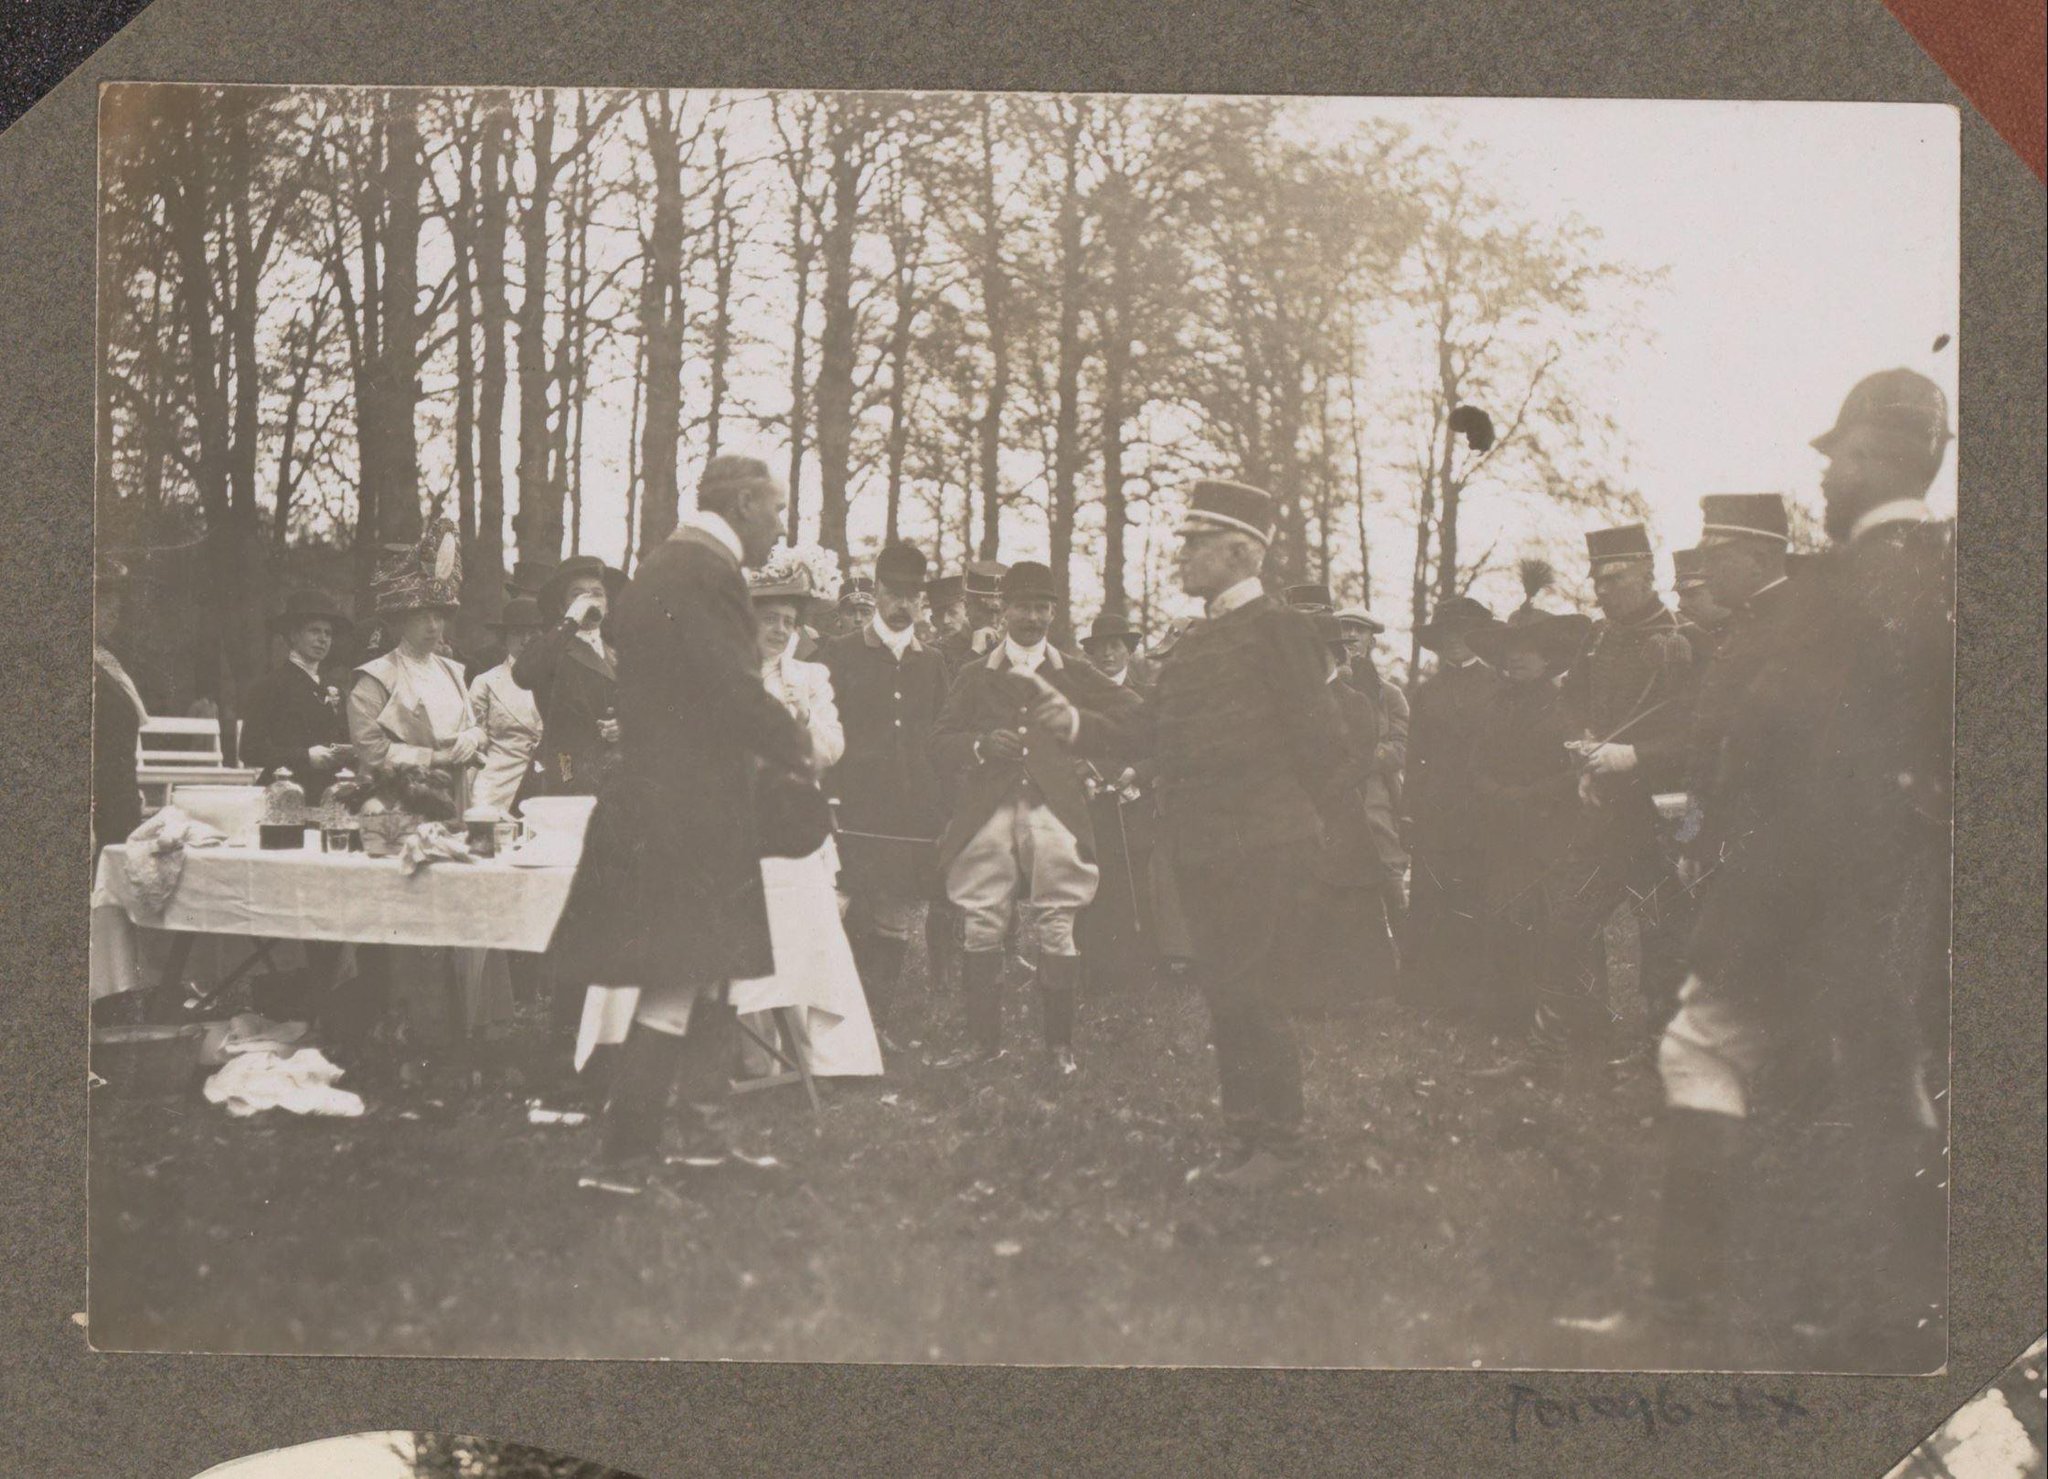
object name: album leaf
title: Ruitertafereel op Koninklijke Houtvesterij Het Loo: gezelschap bij gedekte tafels bij een huis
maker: Anonymous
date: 1900-1925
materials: photographic support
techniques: gelatin silver print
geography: het loo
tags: hunting, chase, hunting-ground, eating and drinking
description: Onderdeel van Fotoalbum van de heer Brams, opperhoutvester van koningin Wilhelmina op Koninklijke Houtvesterij Het Loo.